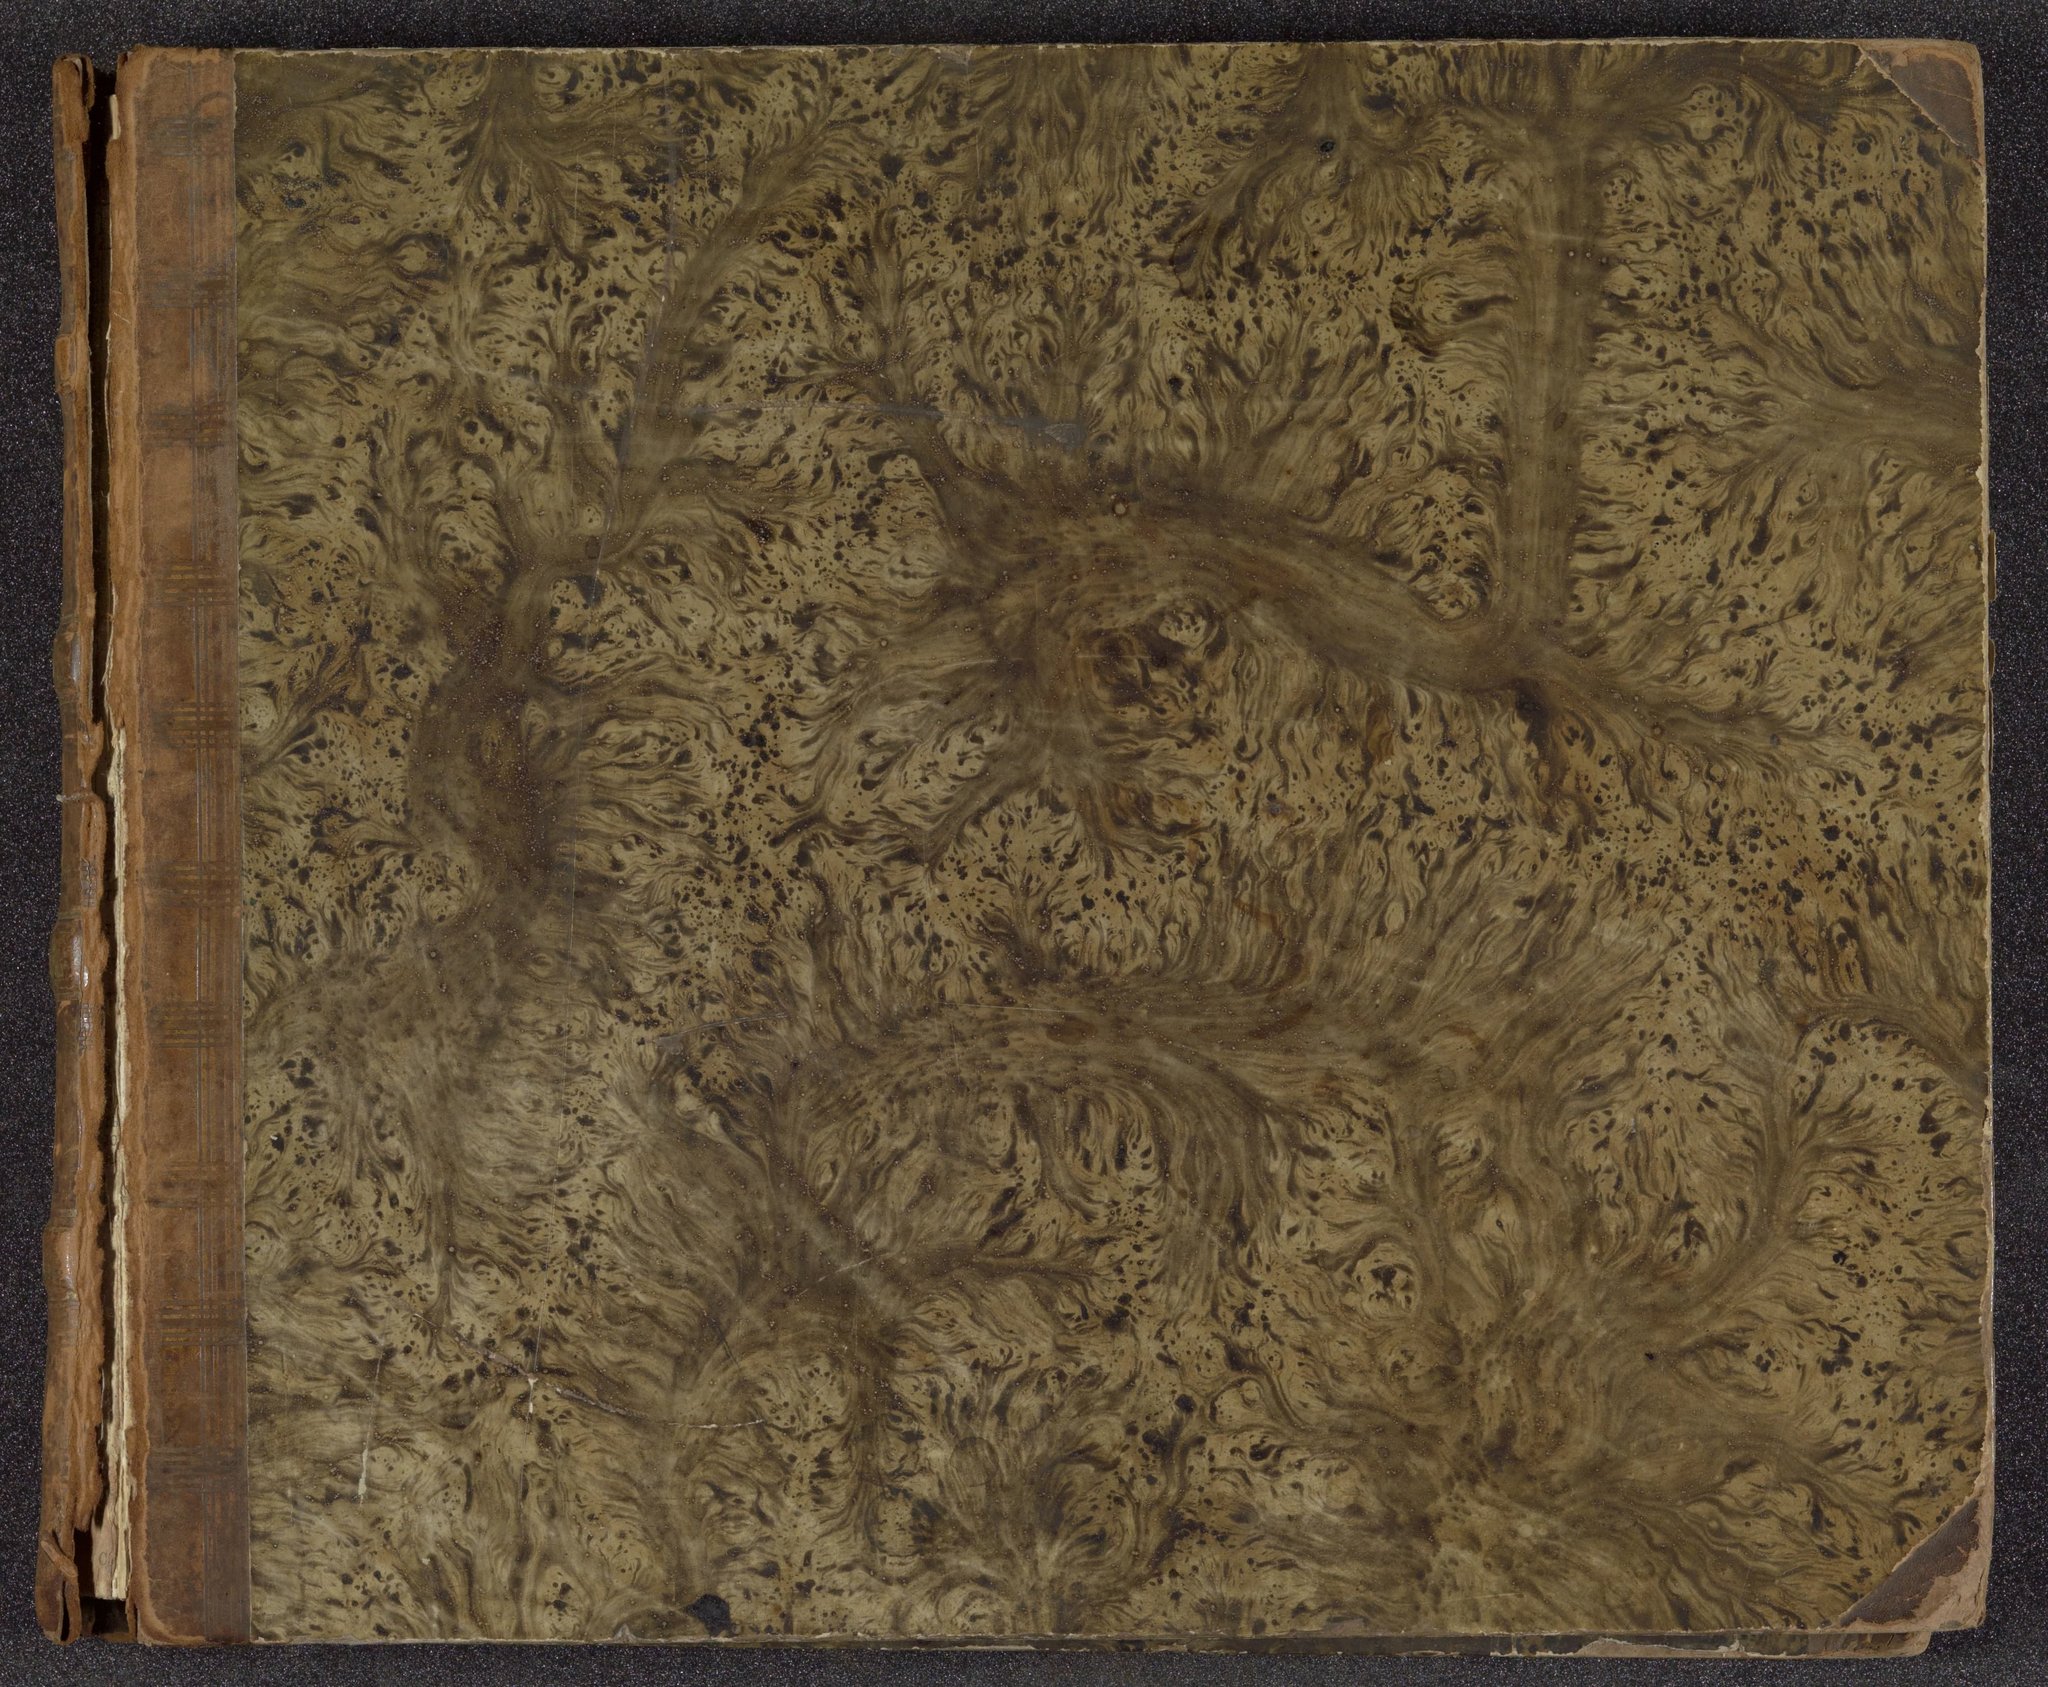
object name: prentrecueil, prentenalbum, prentalbum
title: Album met medaillons met portretten van het geslacht Barbadigo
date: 1673-1743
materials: leather, paper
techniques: bookbinding, engraving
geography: rome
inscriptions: collector's mark: Lugt 2228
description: Album met 164 voorstellingen op 164 albumbladen. De voorstellingen werden gegraveerd in opdracht van Giovanni Francesco Barbarigo. Het gaat om afbeeldingen van medaillons met portretten van leden van de Venetiaanse familie Barbarigo (Barbadicus), ingebed in een kader omgeven door personificaties. Daarnaast een reeks losse allegorische figuren. De personificaties zijn gebaseerd op Ripa's Iconologia. Er zitten verschillende proefdrukken in dit album. De serie prenten werd na de dood van Giovanni Francesco ook in boekvorm uitgegeven onder de titel: Numismata virorum illustrium ex Barbadica gente. Halfleren band met gemarmerde platten, voorin en achterin een schutblad.